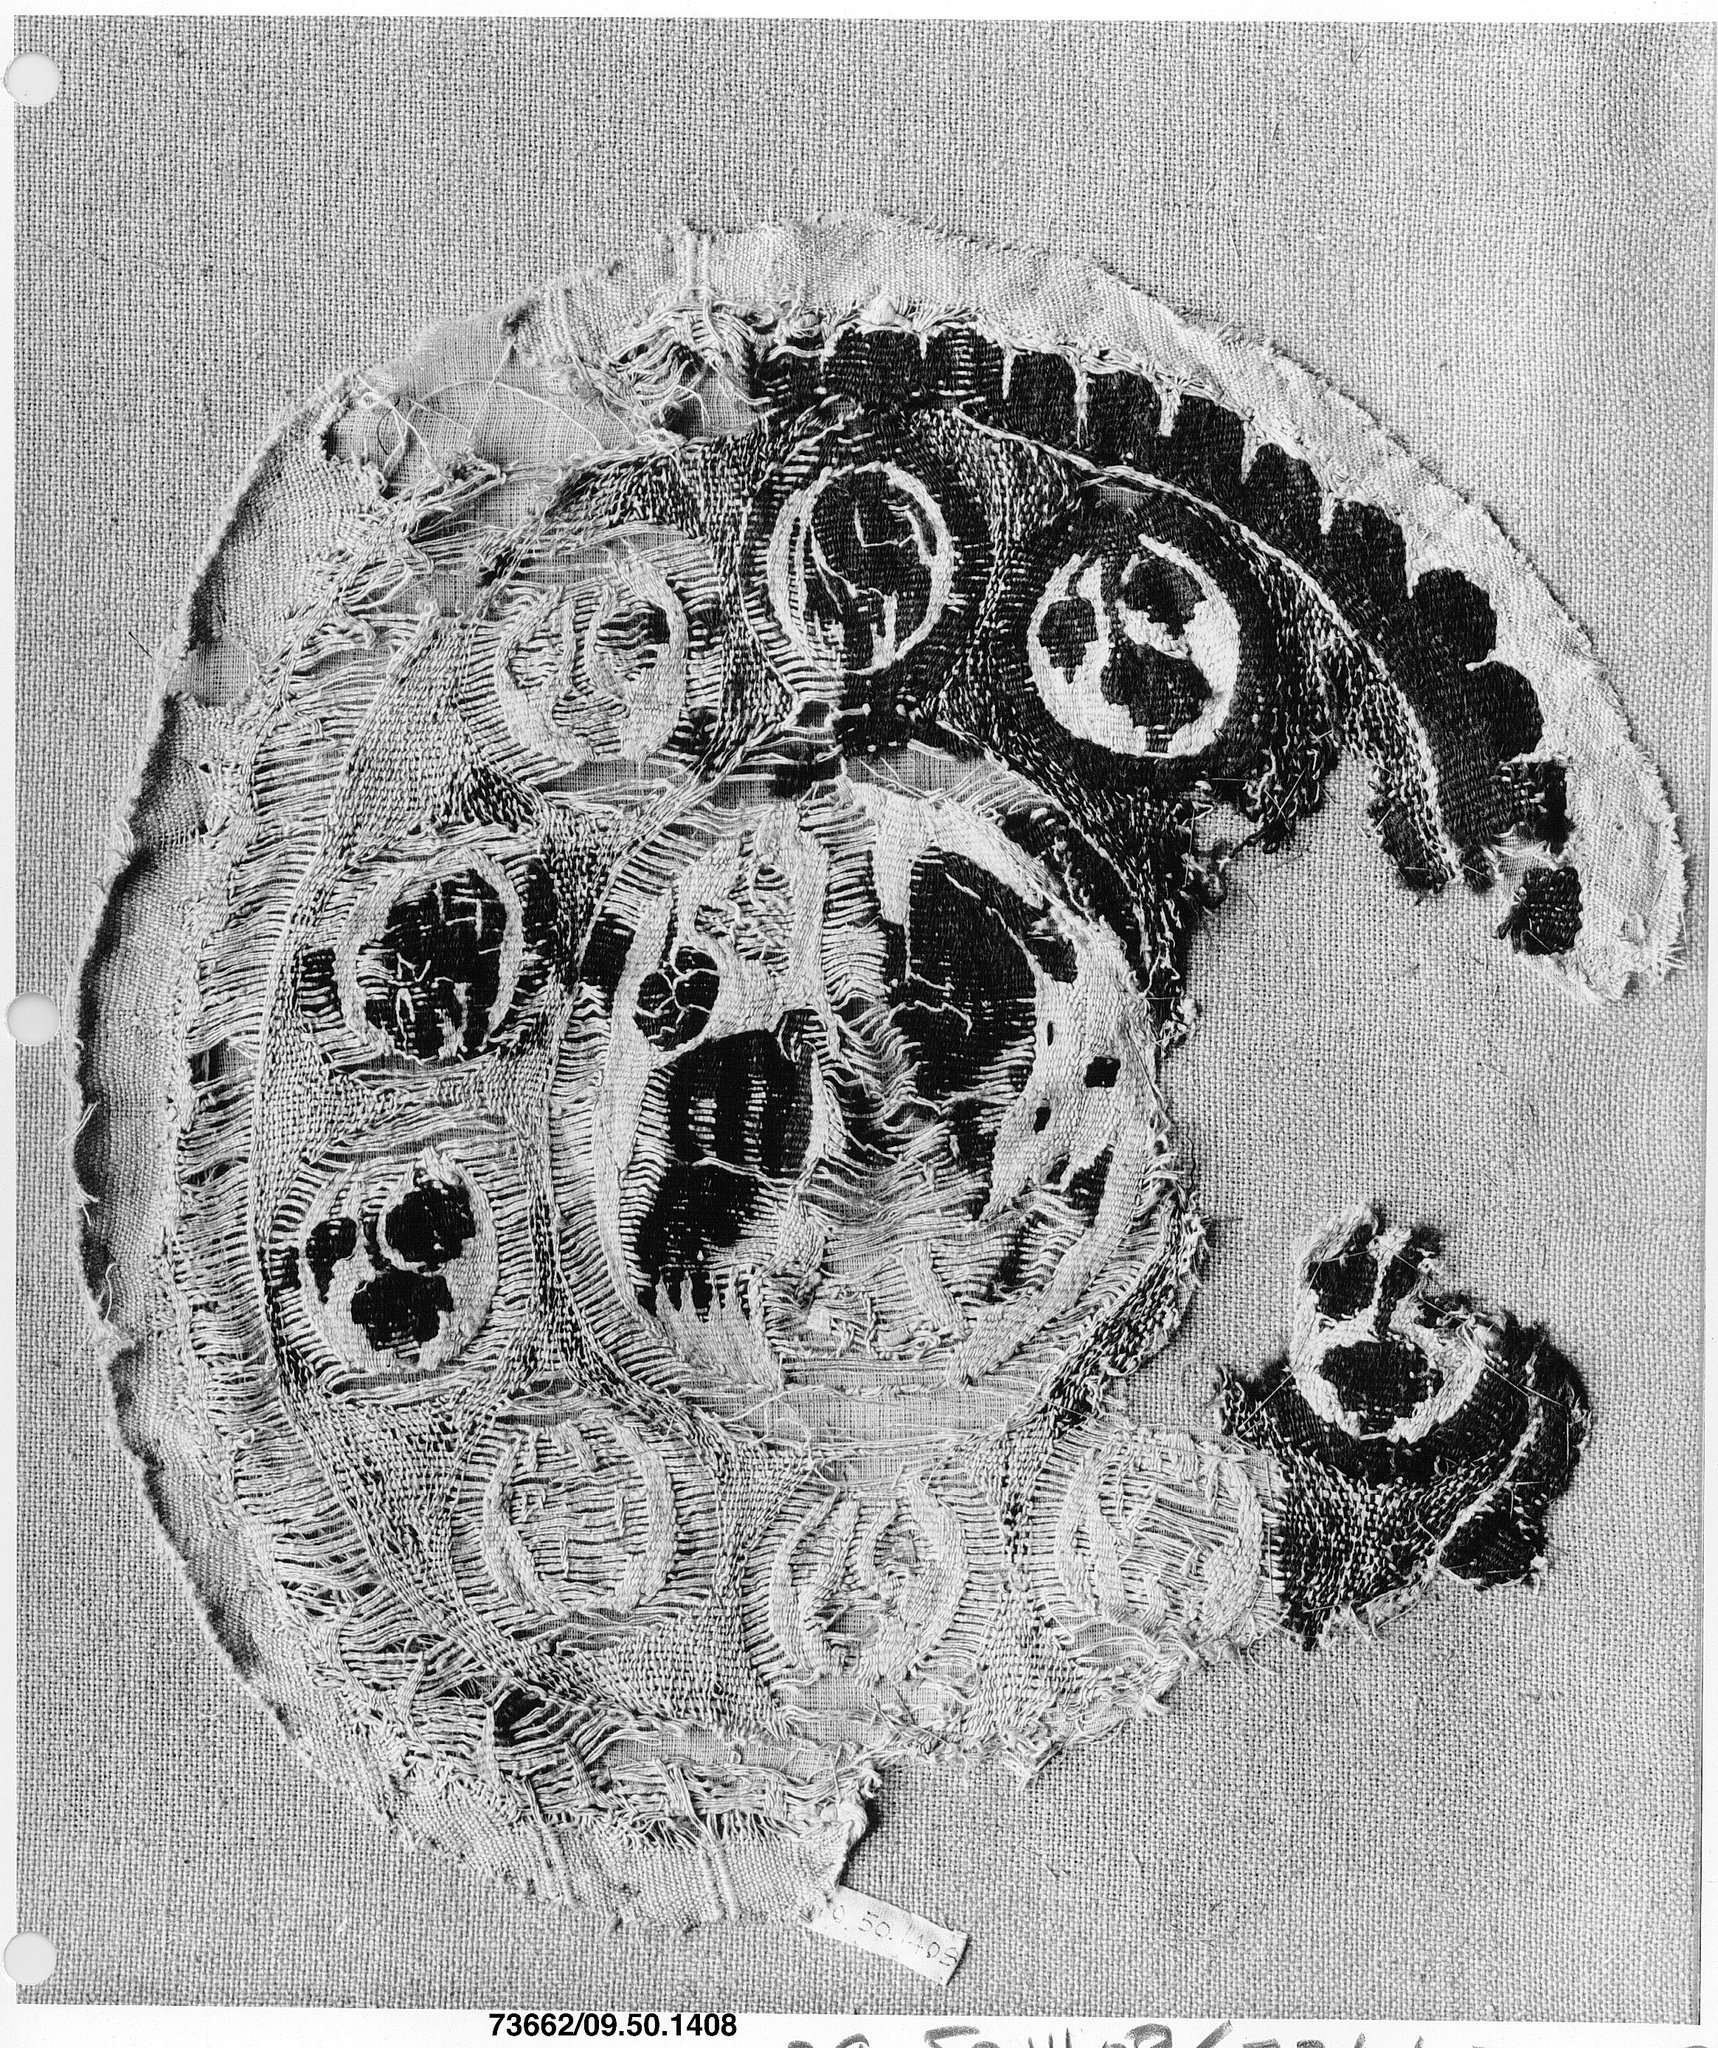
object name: roundel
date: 301-500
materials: linen, wool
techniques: weave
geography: egypt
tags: horses